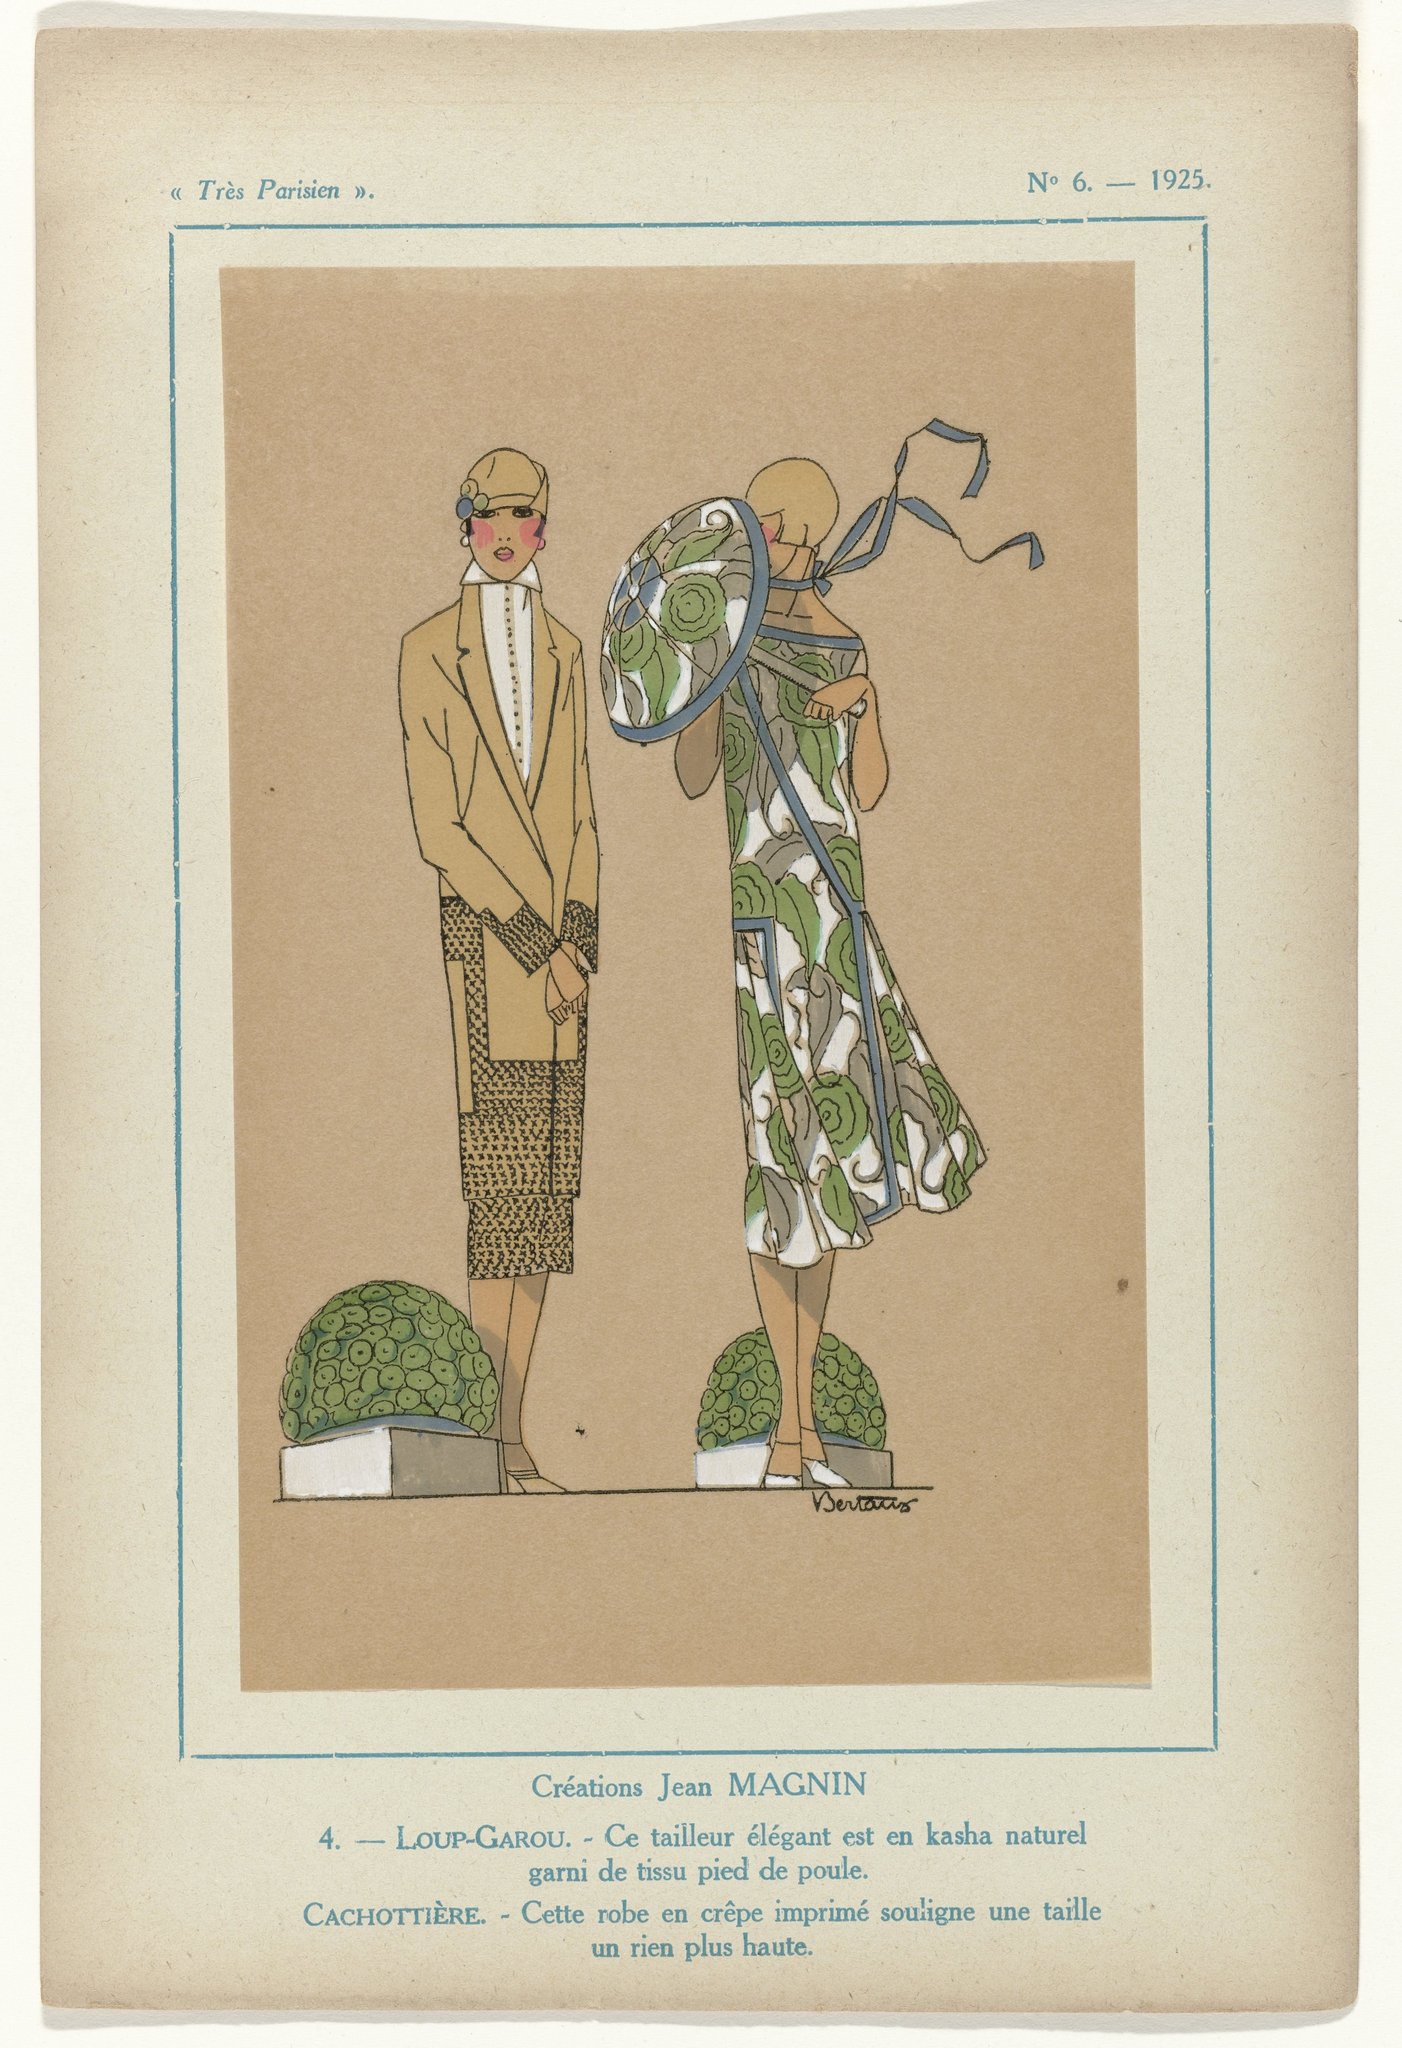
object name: fashion print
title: Très Parisien, 1925, No 6, Pl. 4: Créations Jean MAGNIN. - LOUP-GAROU.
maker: g-p. joumard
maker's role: publisher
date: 1925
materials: paper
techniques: hand coloring, letterpress printing, lithography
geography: paris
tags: dress, gown: day dress (+ women's clothes), ensembles of pieces of clothing (tailleur) (+ women's clothes), fashion plates, parasol, sunshade (+ women's clothes)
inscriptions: caption: ‘4.--LOUP-GAROU. Ce tailleur élégant est en kasha naturel garni de tissu pied de poule. CACHOTTIÈRE. - Cette robe en crêpe imprimé souligne une taille un rien plus haute.’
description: Loup-Garou: mantelpak en Cachottière: japon van crêpe. Parasol in dezelfde stof als de japon. Prent uit het modetijdschrift Très Parisien...La Mode, Le Chic, L'Élégance (1920-1936)